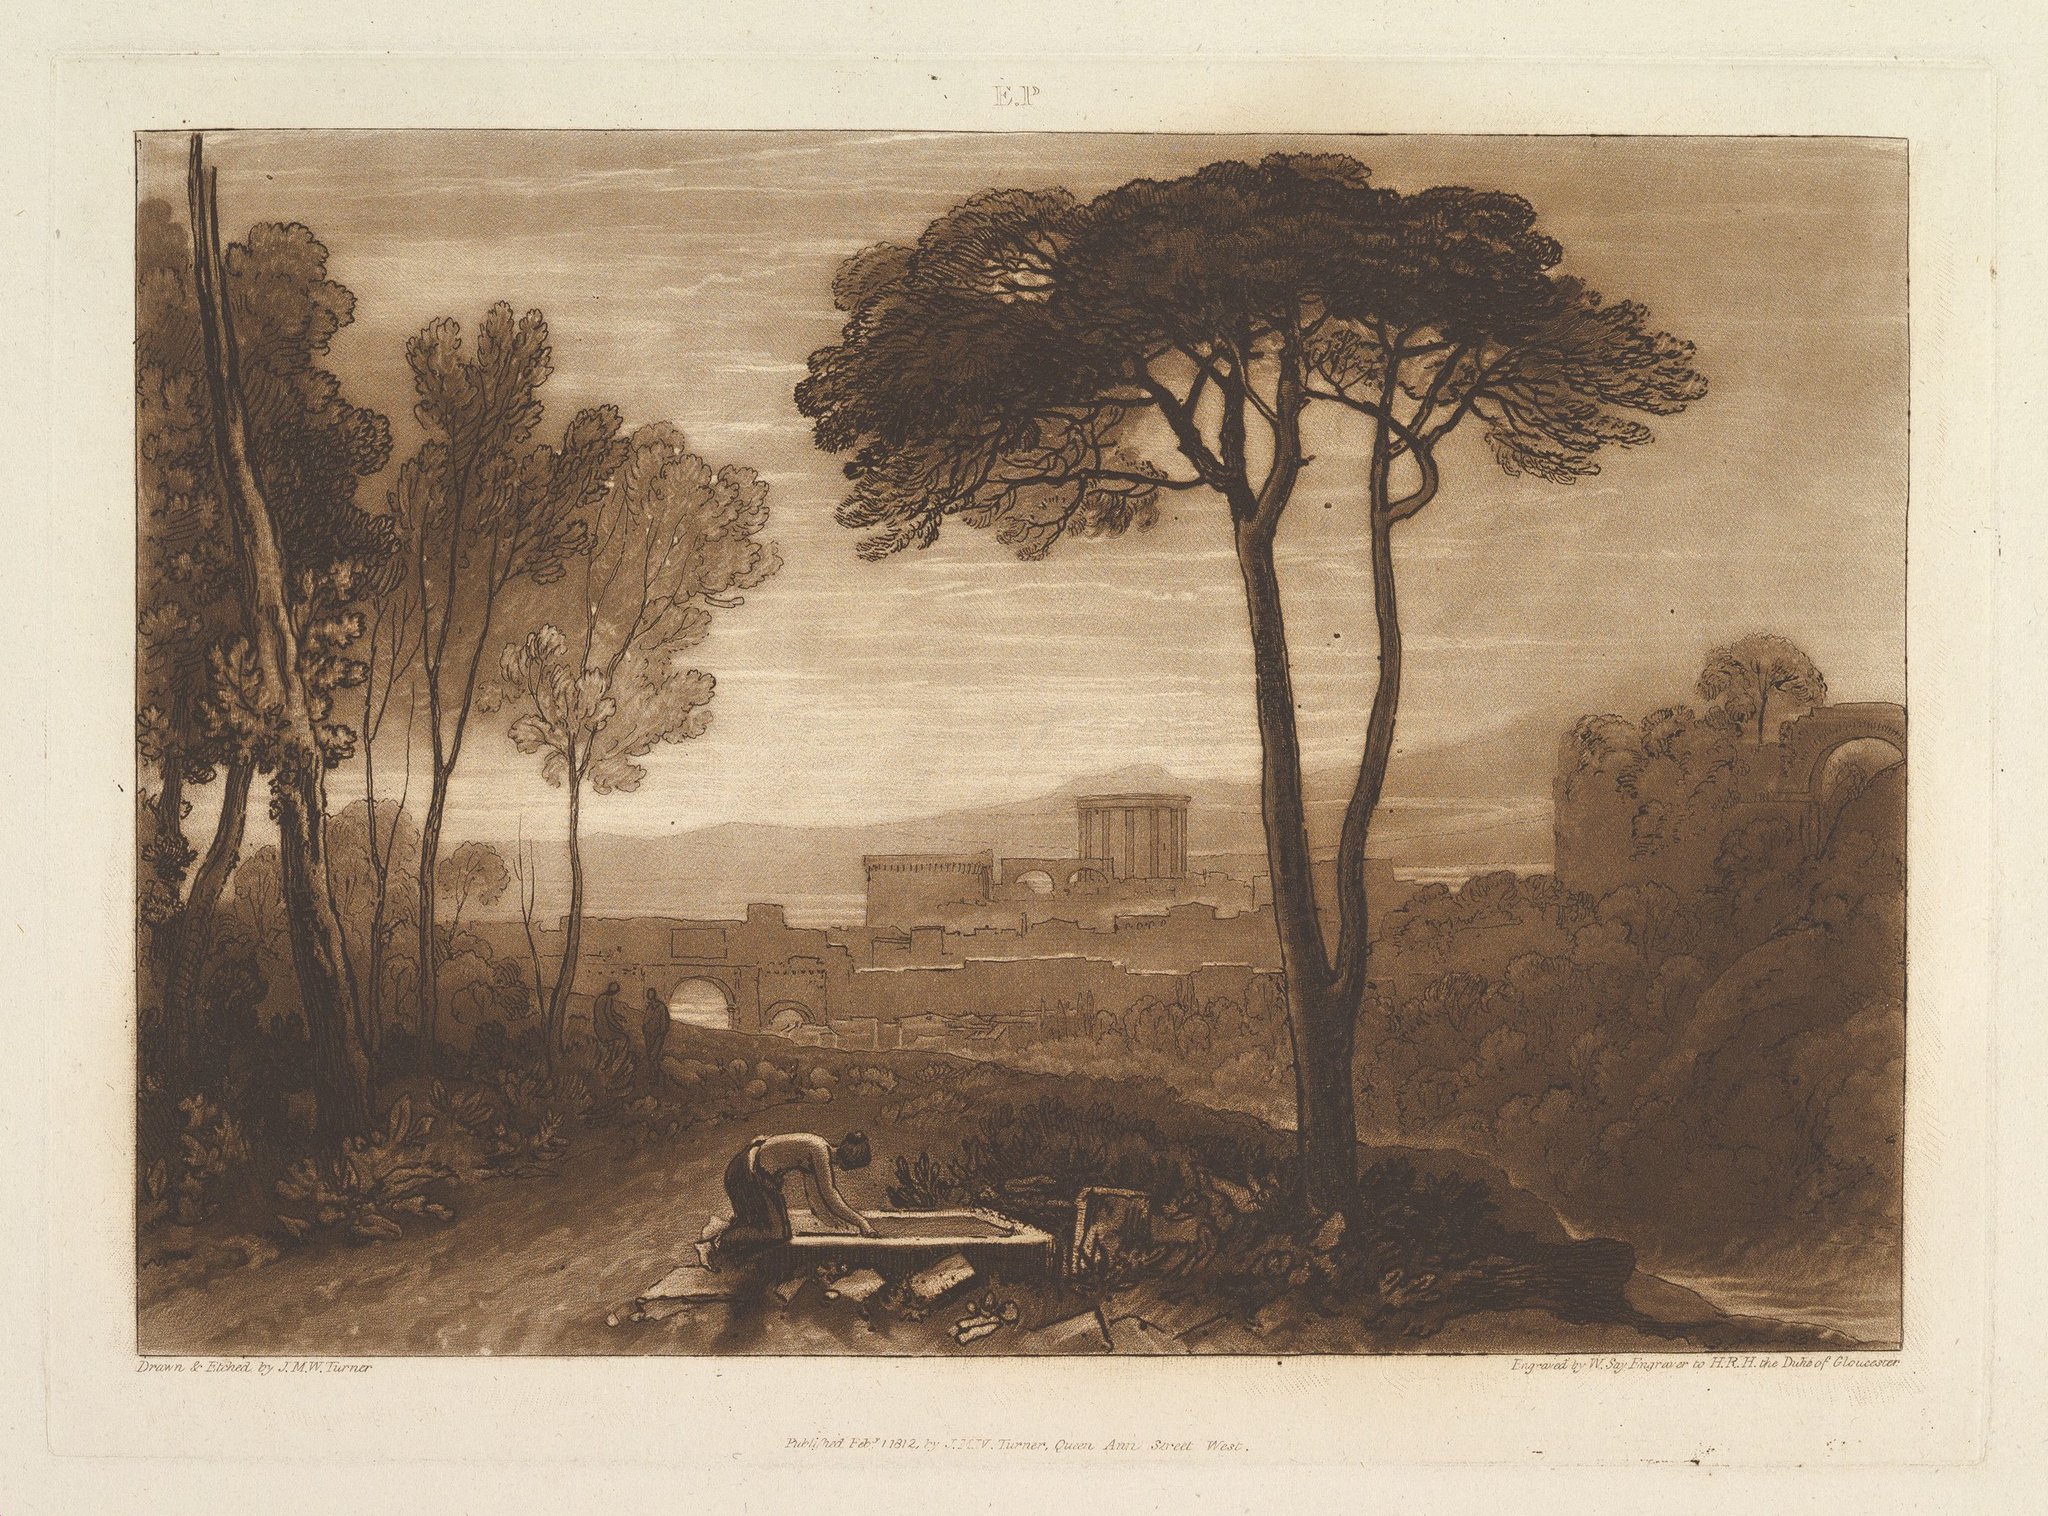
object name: print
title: Scene in the Campagna, part ViII, plate 38 from "Liber Studiorum"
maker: joseph mallord william turner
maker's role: artist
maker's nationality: british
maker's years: 1775-1851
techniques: etching, mezzotint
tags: bridges,women,rivers,landscapes,trees